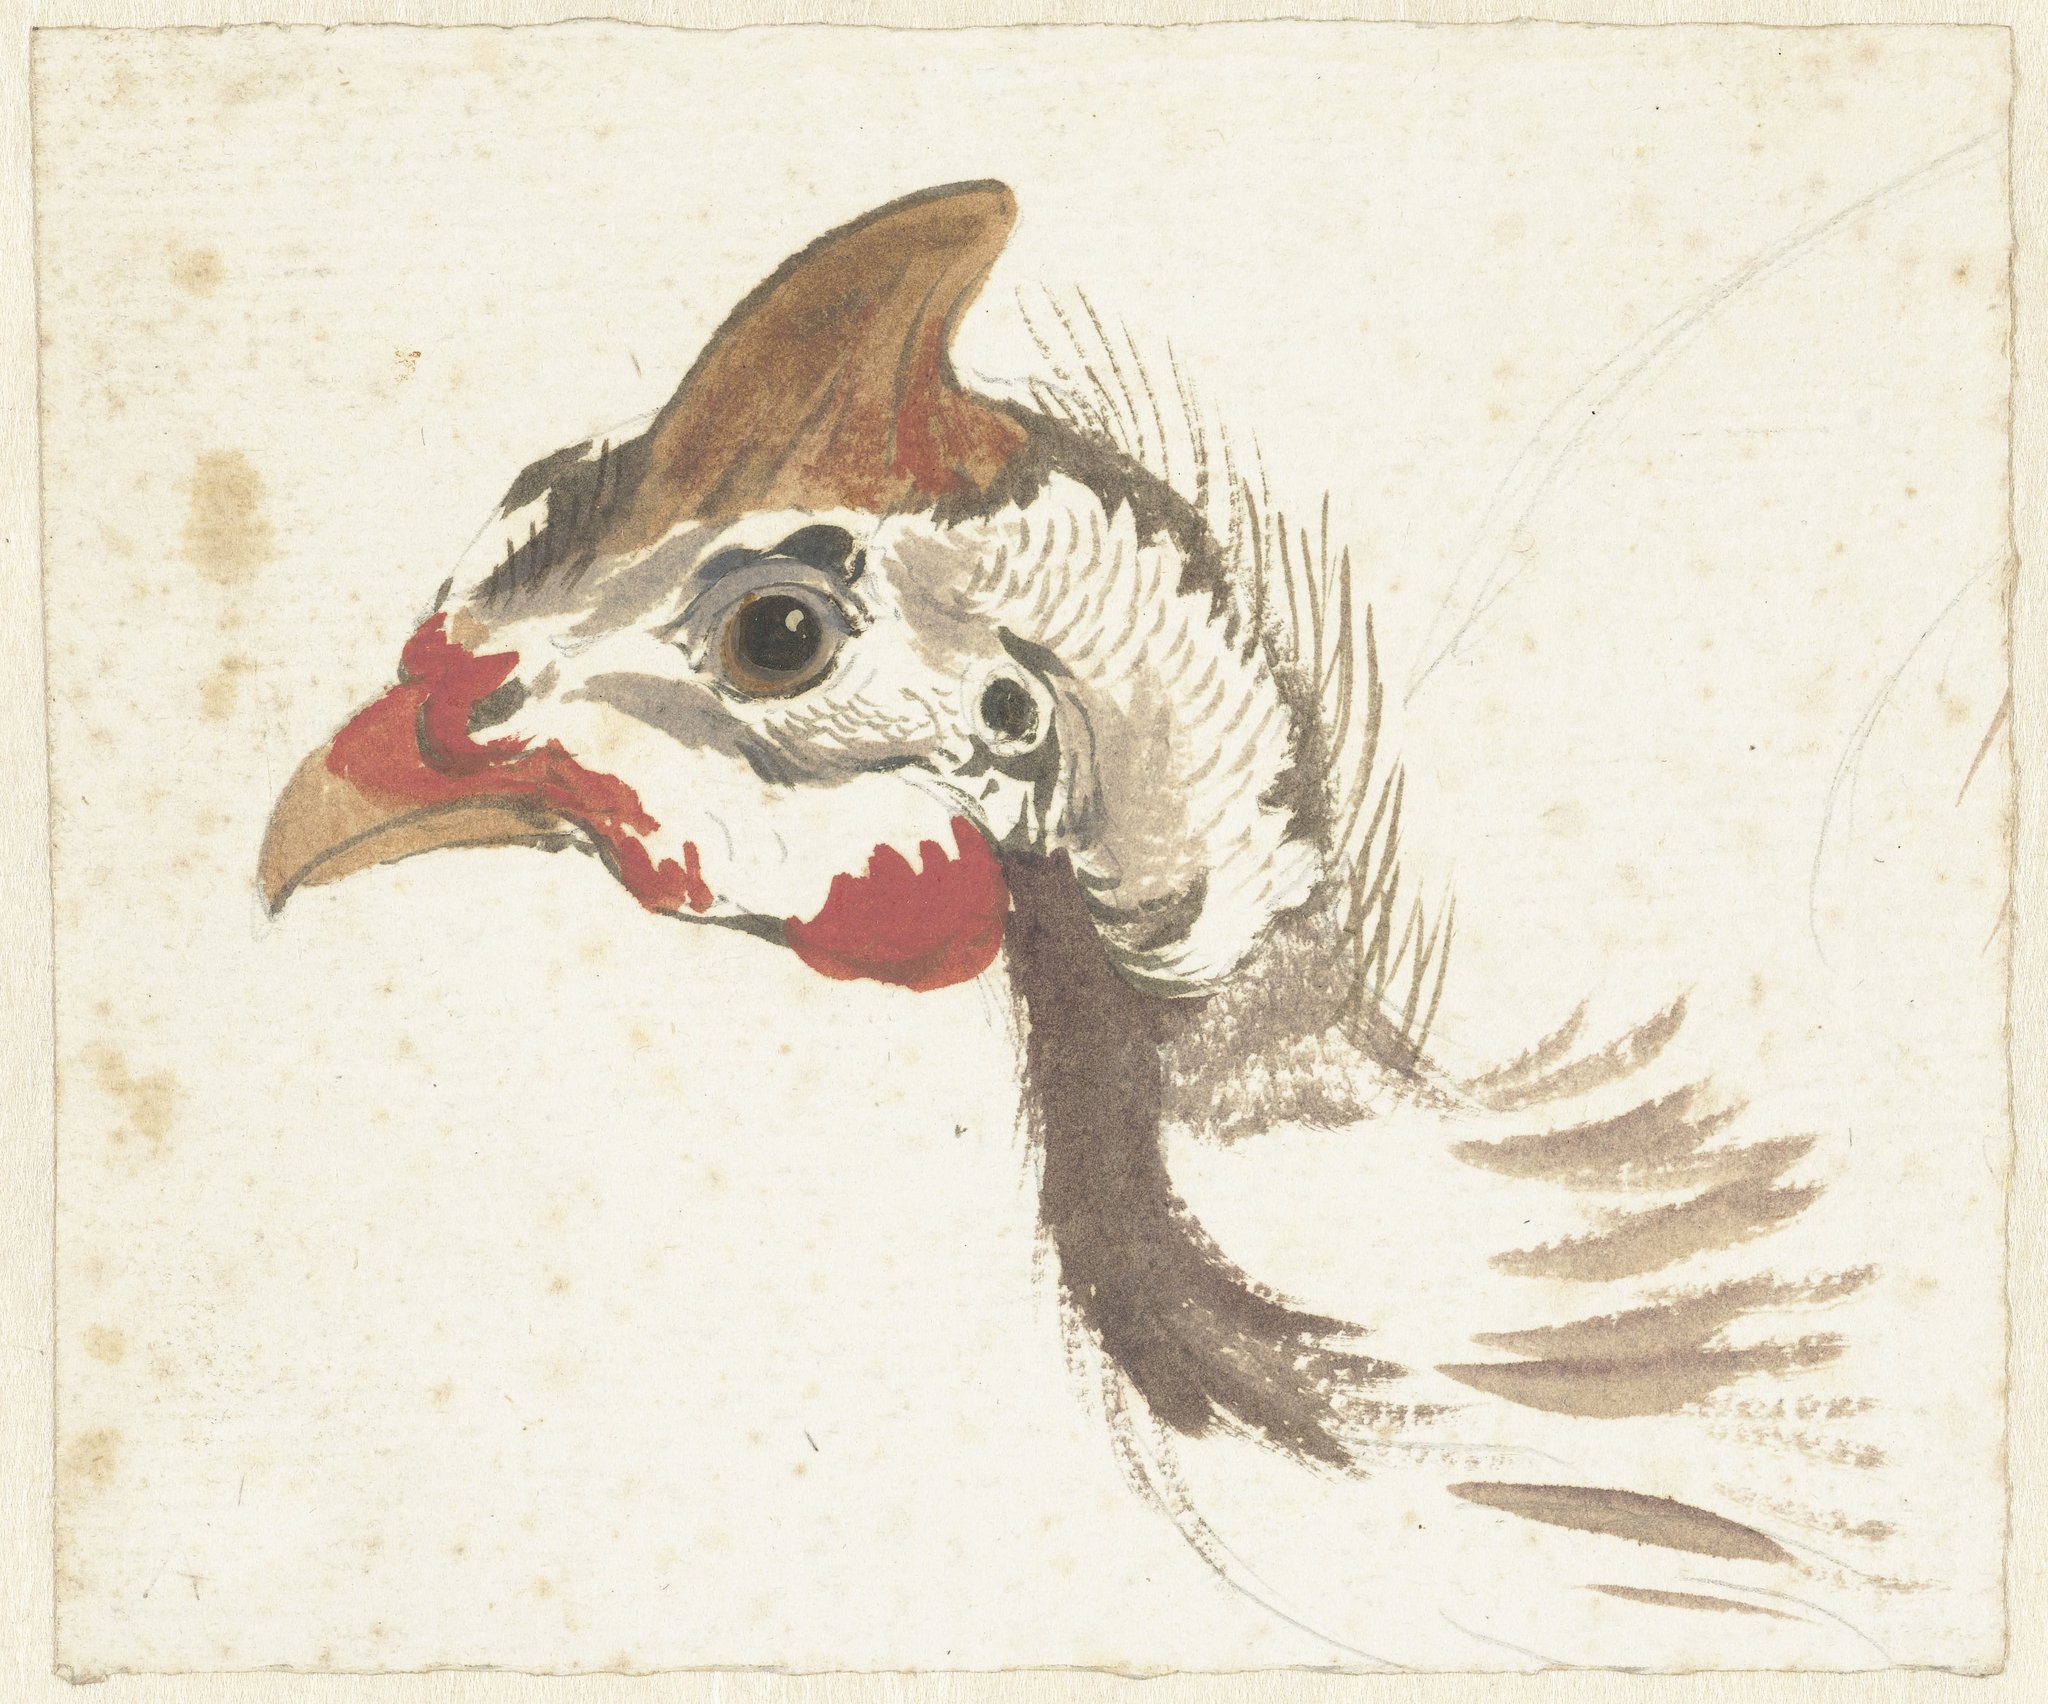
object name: drawing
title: Head of a Helmeted Guineafowl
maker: aert schouman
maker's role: draughtsman, painter, print maker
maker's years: 1710-1792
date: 1720-1792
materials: paper, pencil, watercolor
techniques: brush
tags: birds (+ snout, jaw, beak, nib)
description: Kop naar links gewend van een helmparelhoen (Numida meleagris).